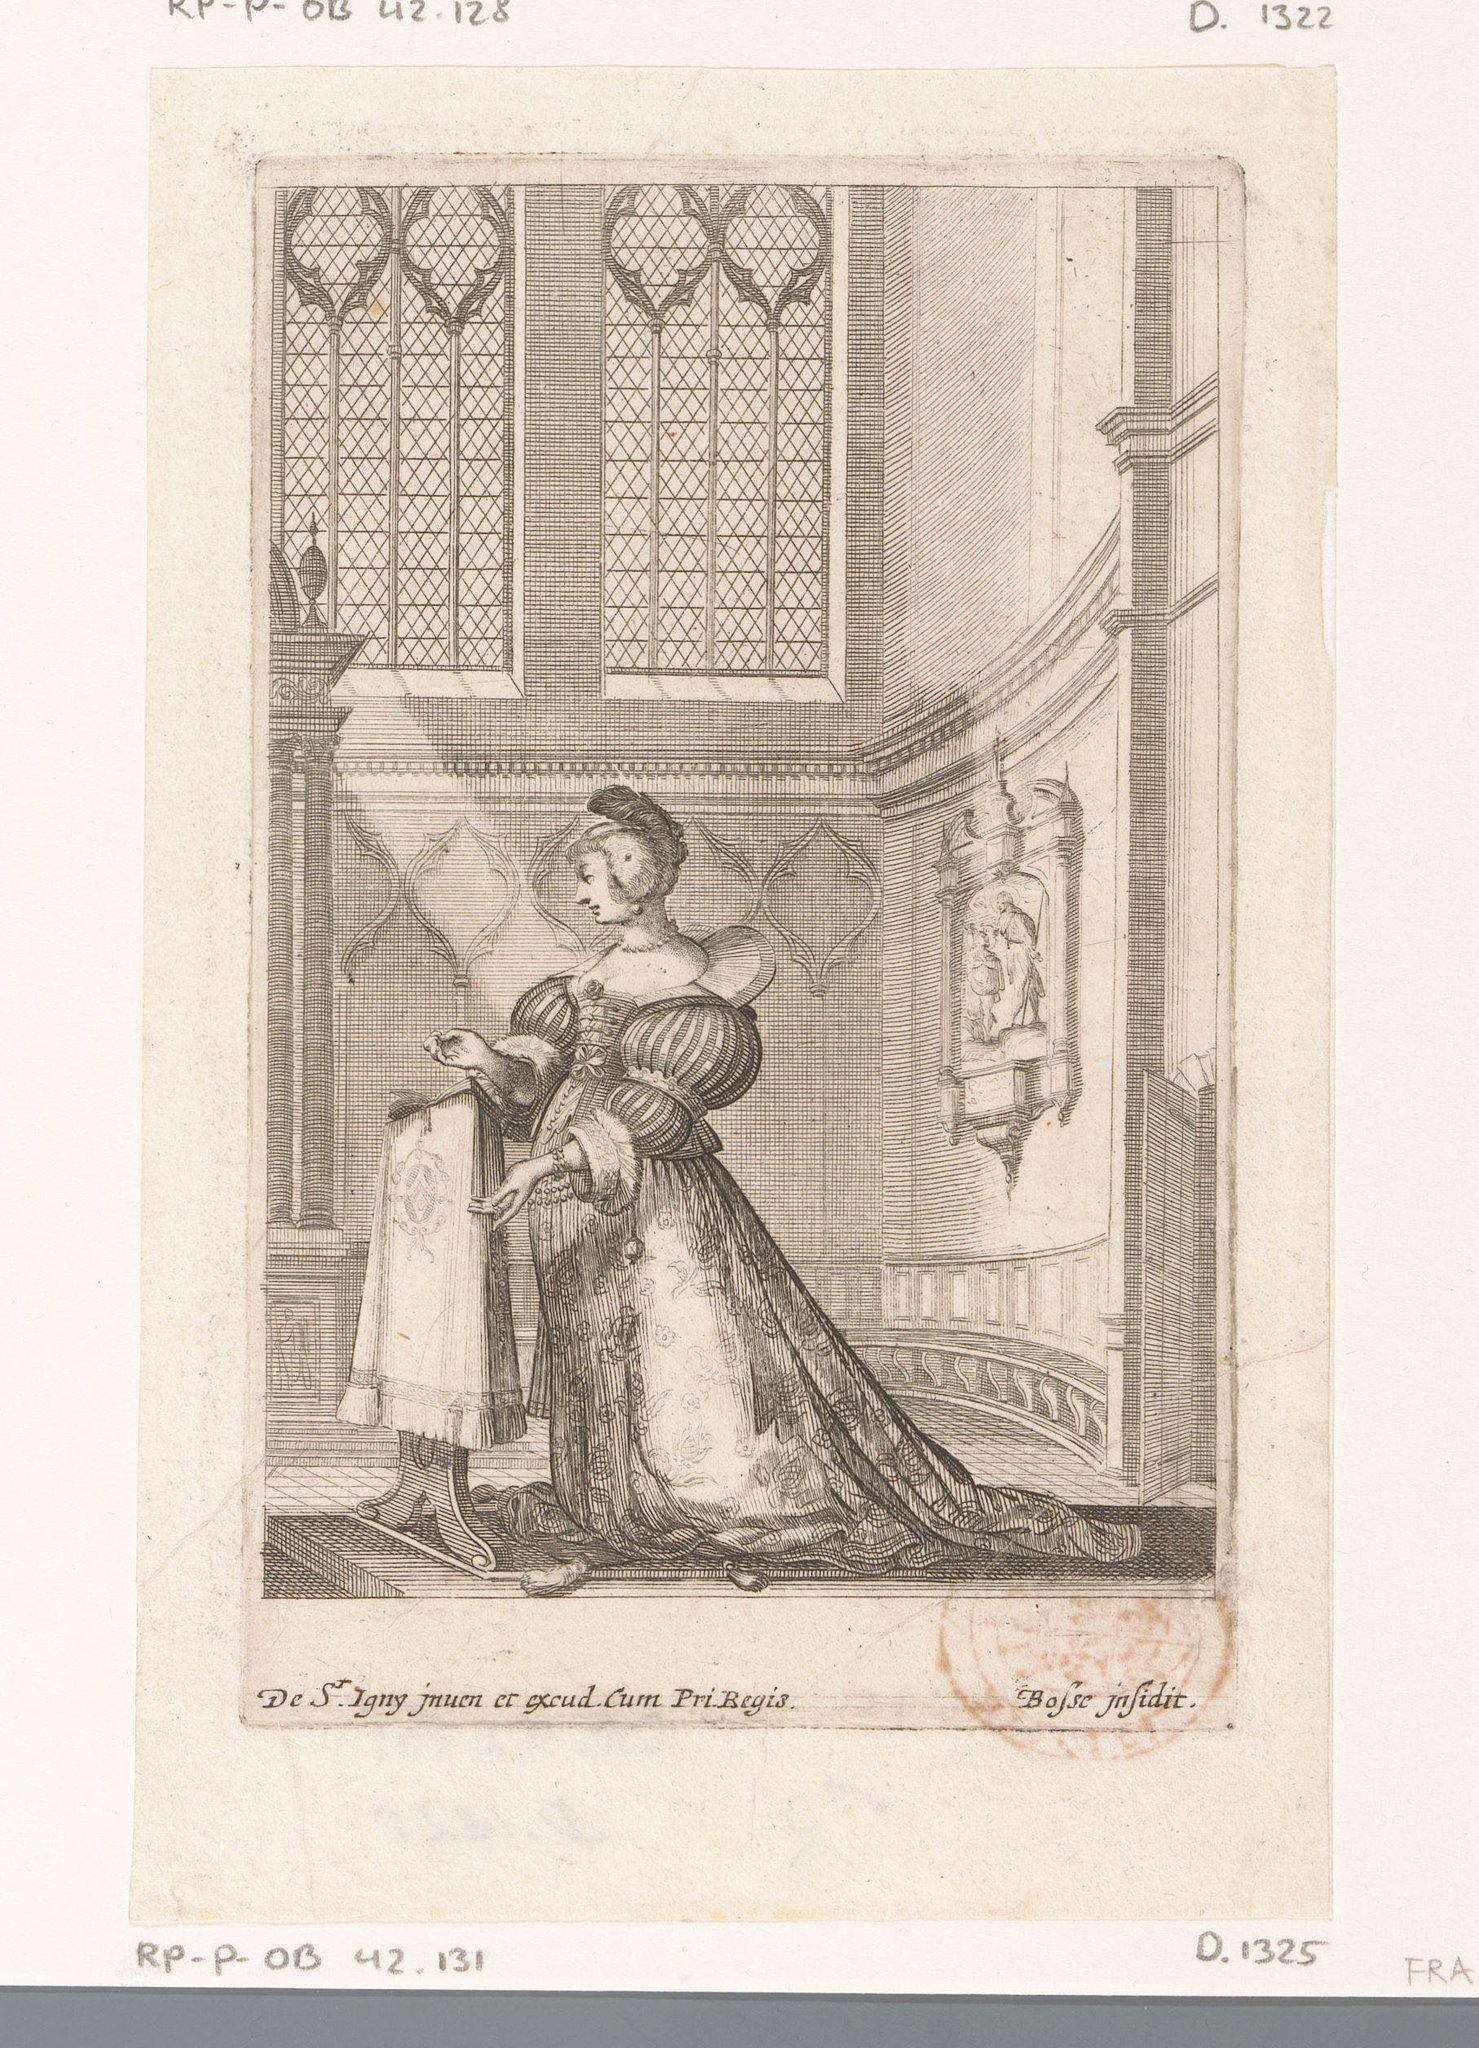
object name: costume print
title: La Noblesse Française à l’église (The French Nobility at Church)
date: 1628-1629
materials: paper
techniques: engraving, etching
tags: ear-rings (+ women's clothes), reading, styles of hairdress - aa - ~ women, head-gear: cap (+ women's clothes), neck-gear: collar (+ women's clothes), clothes, costume (+ women's clothes), skirt (+ women's clothes), sleeves: cuffs (+ women's clothes), dress, gown (+ women's clothes), interior of church, sleeves (+ women's clothes), necklace (+ women's clothes), clothing for the upper part of the body (with name) (+ women's clothes)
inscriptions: collector's mark: Lugt 240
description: Bosse portrayed the Gothic churches of Paris as sites of piety and fashionability. While praying or merely strutting through the centuries-old architecture, the churchgoers in these prints sport the latest styles. For example, in the few years since Callot’s series (adjacent), an ornate and expensive form of lace cutwork – reticella – had become a popular form of decoration for collars and cuffs.